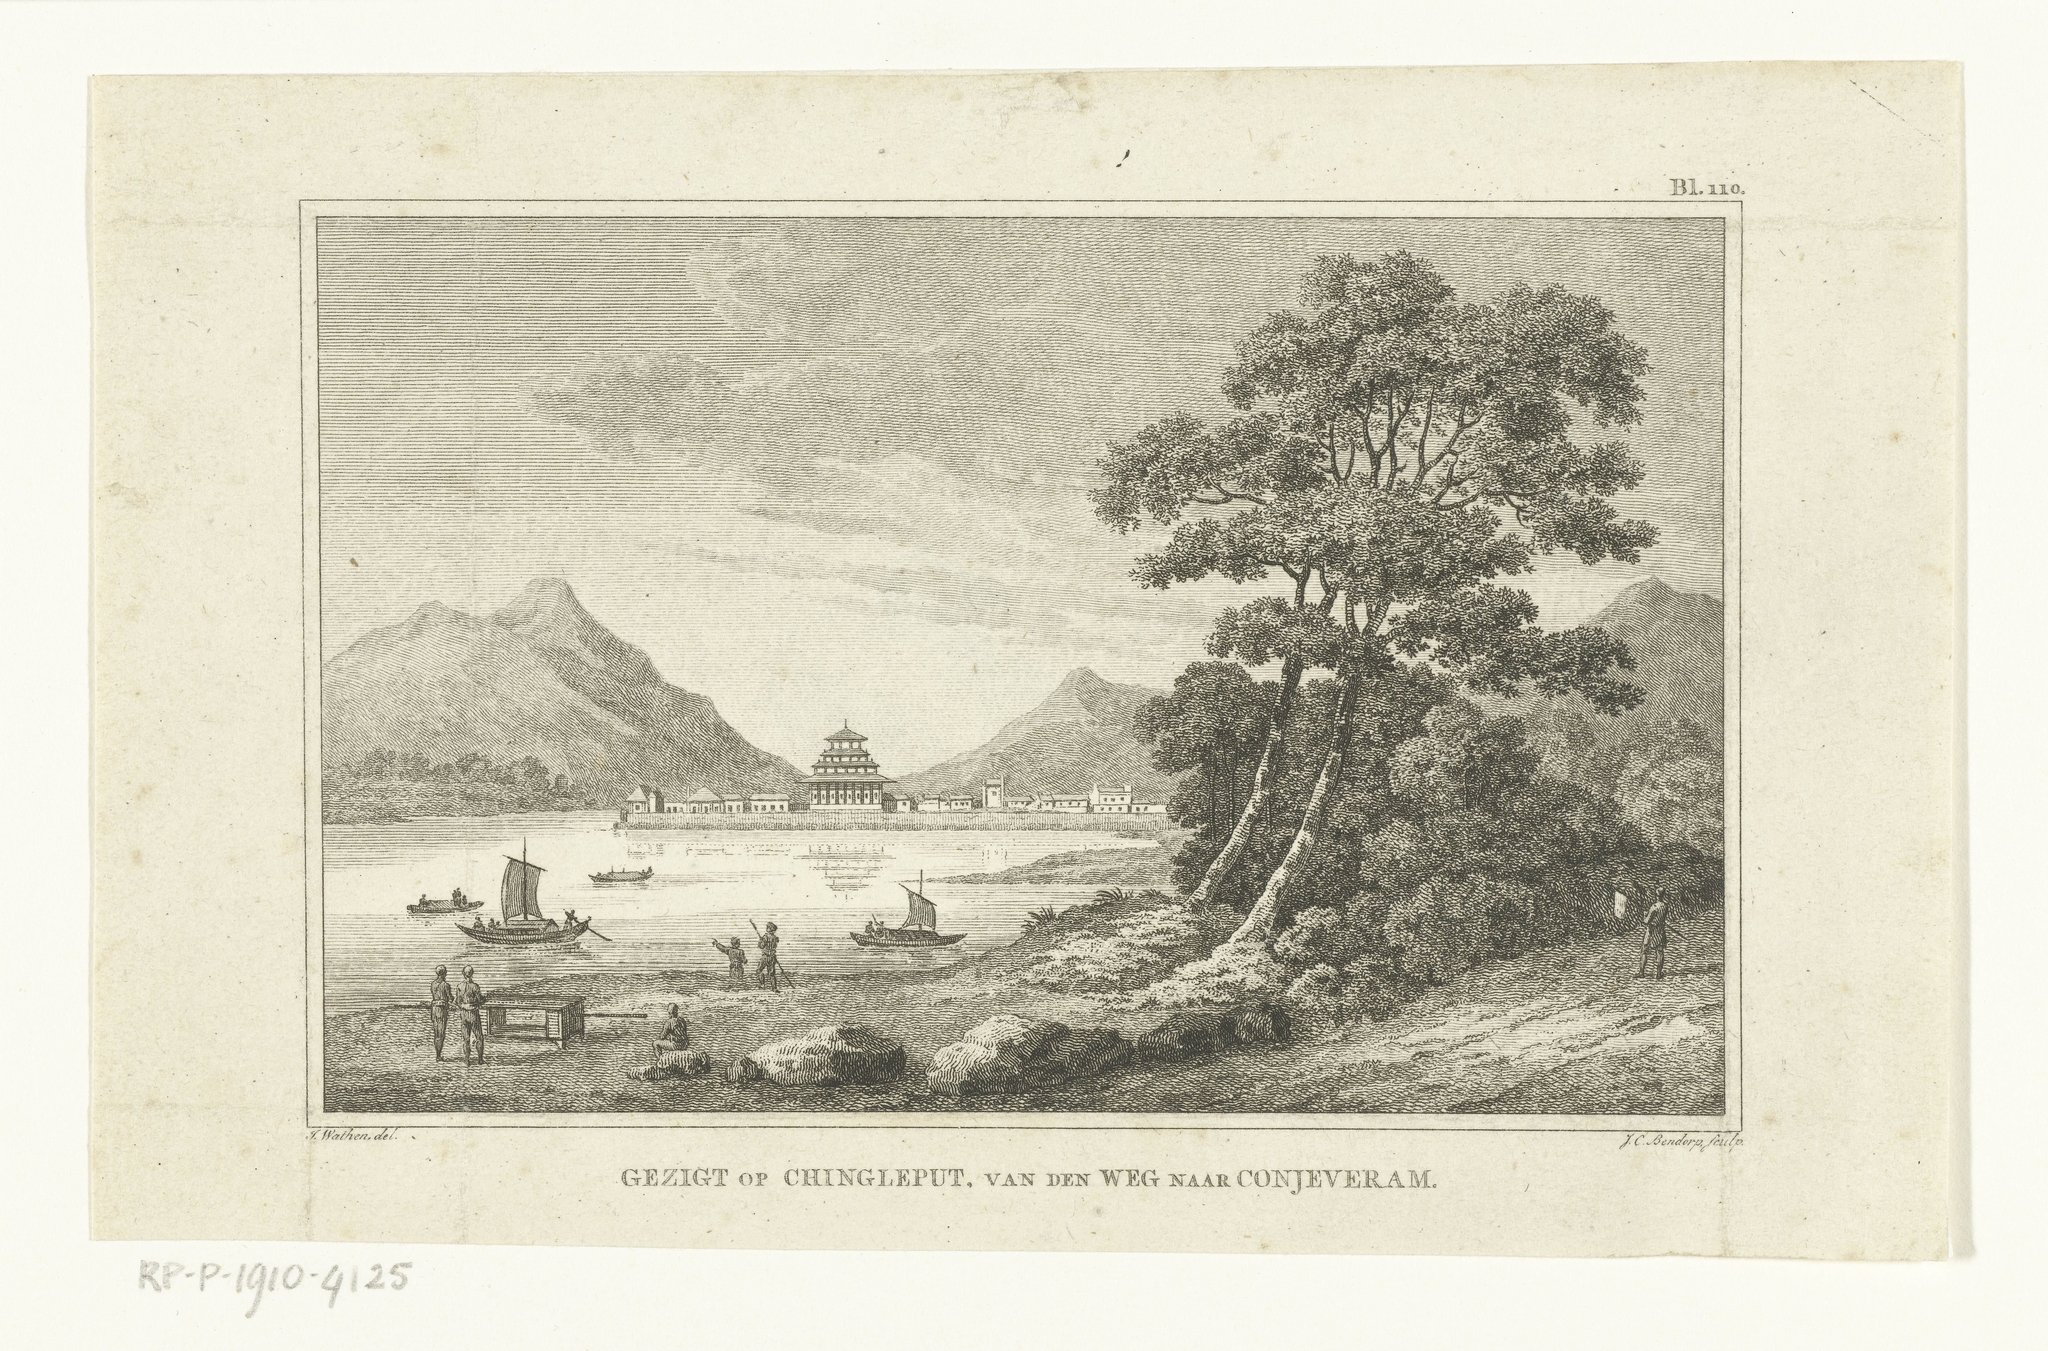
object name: print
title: Gezicht op Chengalpattu vanaf de weg naar Conjeveram te India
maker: johannes christiaan bendorp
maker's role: print maker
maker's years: 1766-1849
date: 1776-1816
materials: paper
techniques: etching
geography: netherlands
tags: chengalpattu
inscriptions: collector's mark: Lugt 2228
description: Boekillustratie uit: Wathen, James en Nicolaas Messchaert (vertaling), Reis naar Madras en China en terug over St. Helena, A. Blusse & Zoon (uitgever), Dordrecht 1816, tegenover titelpagina, illustratie bij reisverslag op p. 110 aldus opschrift.